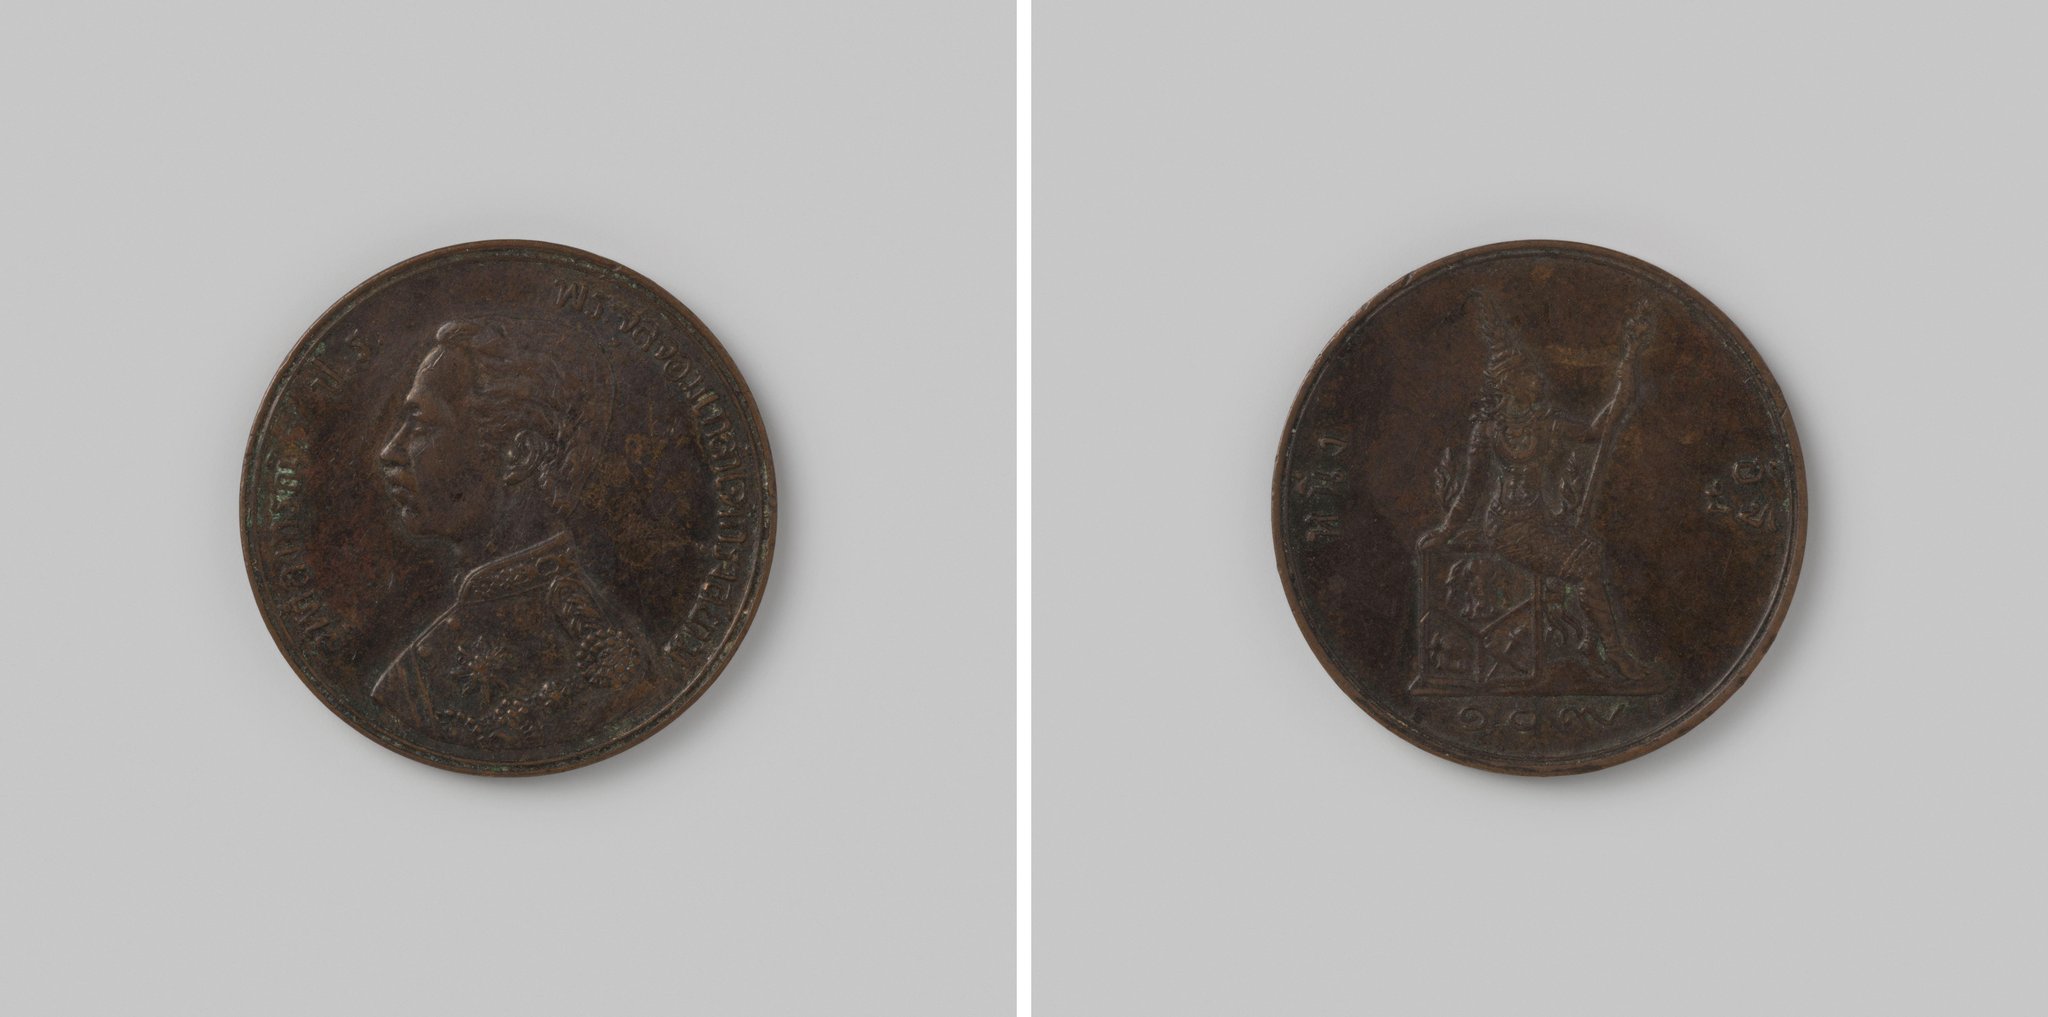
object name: coin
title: Thailand, koning Chulalongkorn, att, 109 [=1890]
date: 1890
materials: copper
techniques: striking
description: Koperen munt. Voorzijde: borstbeeld van de koning naar links. Keerzijde: Siam naar rechts met staf, gezeten op het Thaise wapenschild. Waarde-aanduiding rondom. In afsnede jaartal in telling van Bangkok: 109. Gladde rand.